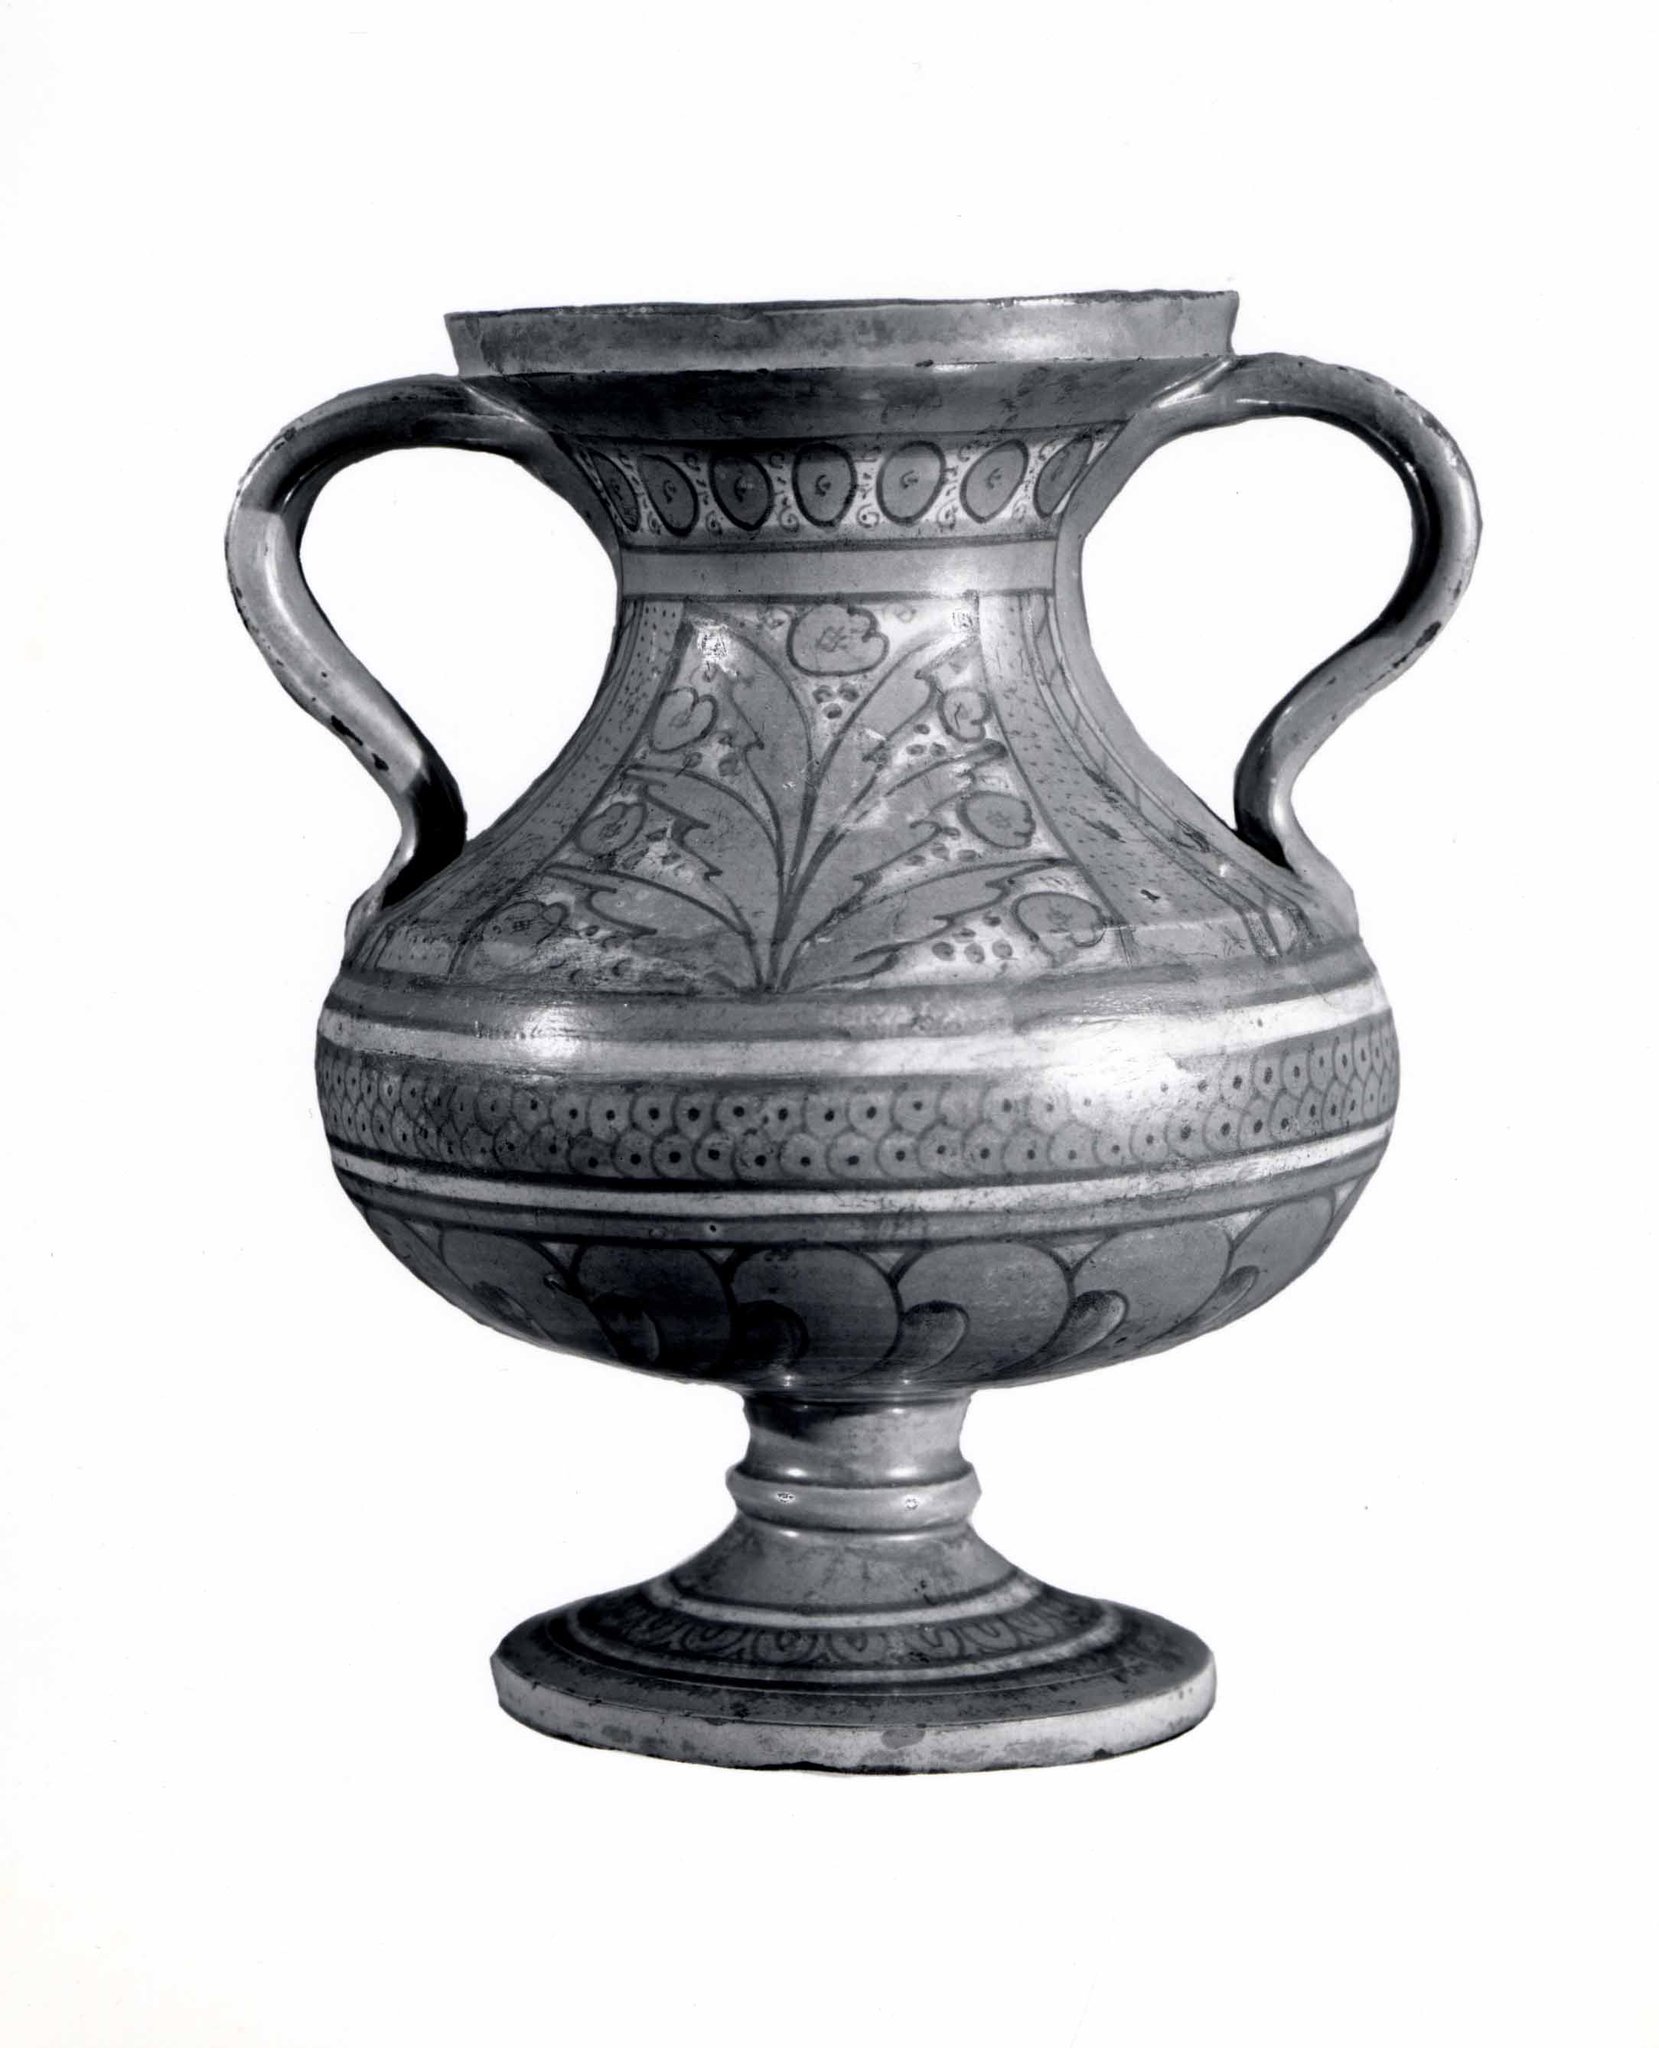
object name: vase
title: Vase (vaso)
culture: italian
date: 1520-1530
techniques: maiolica, glazing